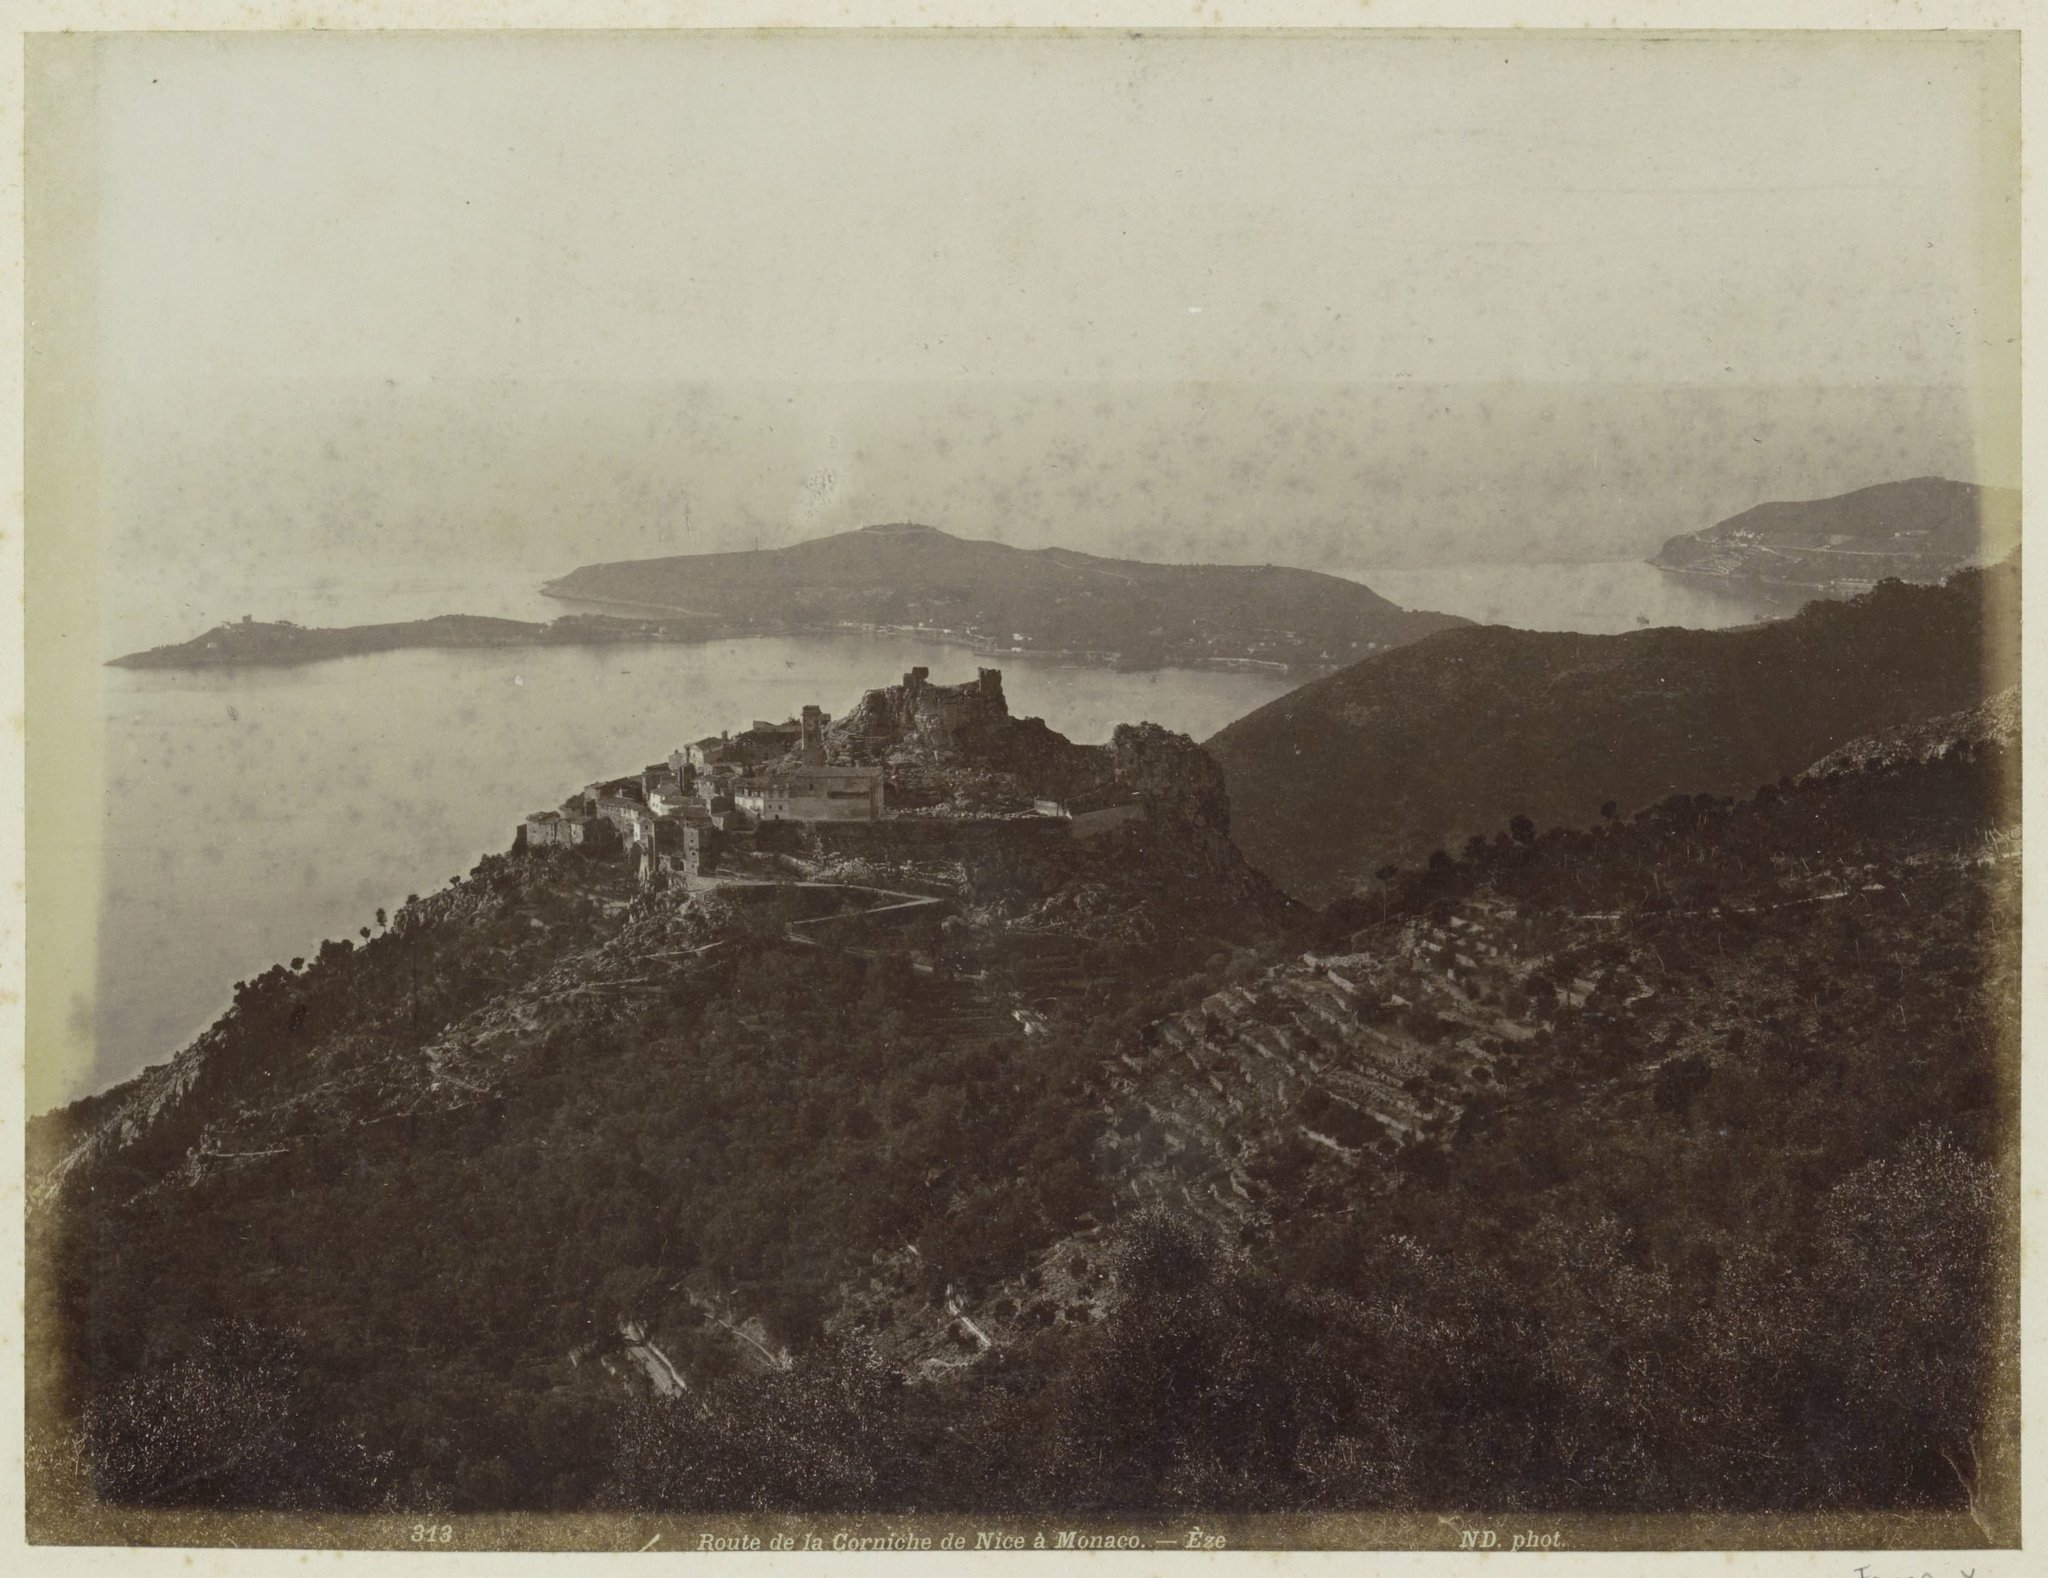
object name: photograph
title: Gezicht op Èze tussen Nice en Monaco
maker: étienne neurdein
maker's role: publisher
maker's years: 1832-1918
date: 1870-1900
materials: paper, photographic support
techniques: albumen print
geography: eze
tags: prospect of village, silhouette of village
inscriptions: negative number: ‘313’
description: Onderdeel van Reisalbum met foto's van bezienswaardigheden in Italië en Frankrijk.